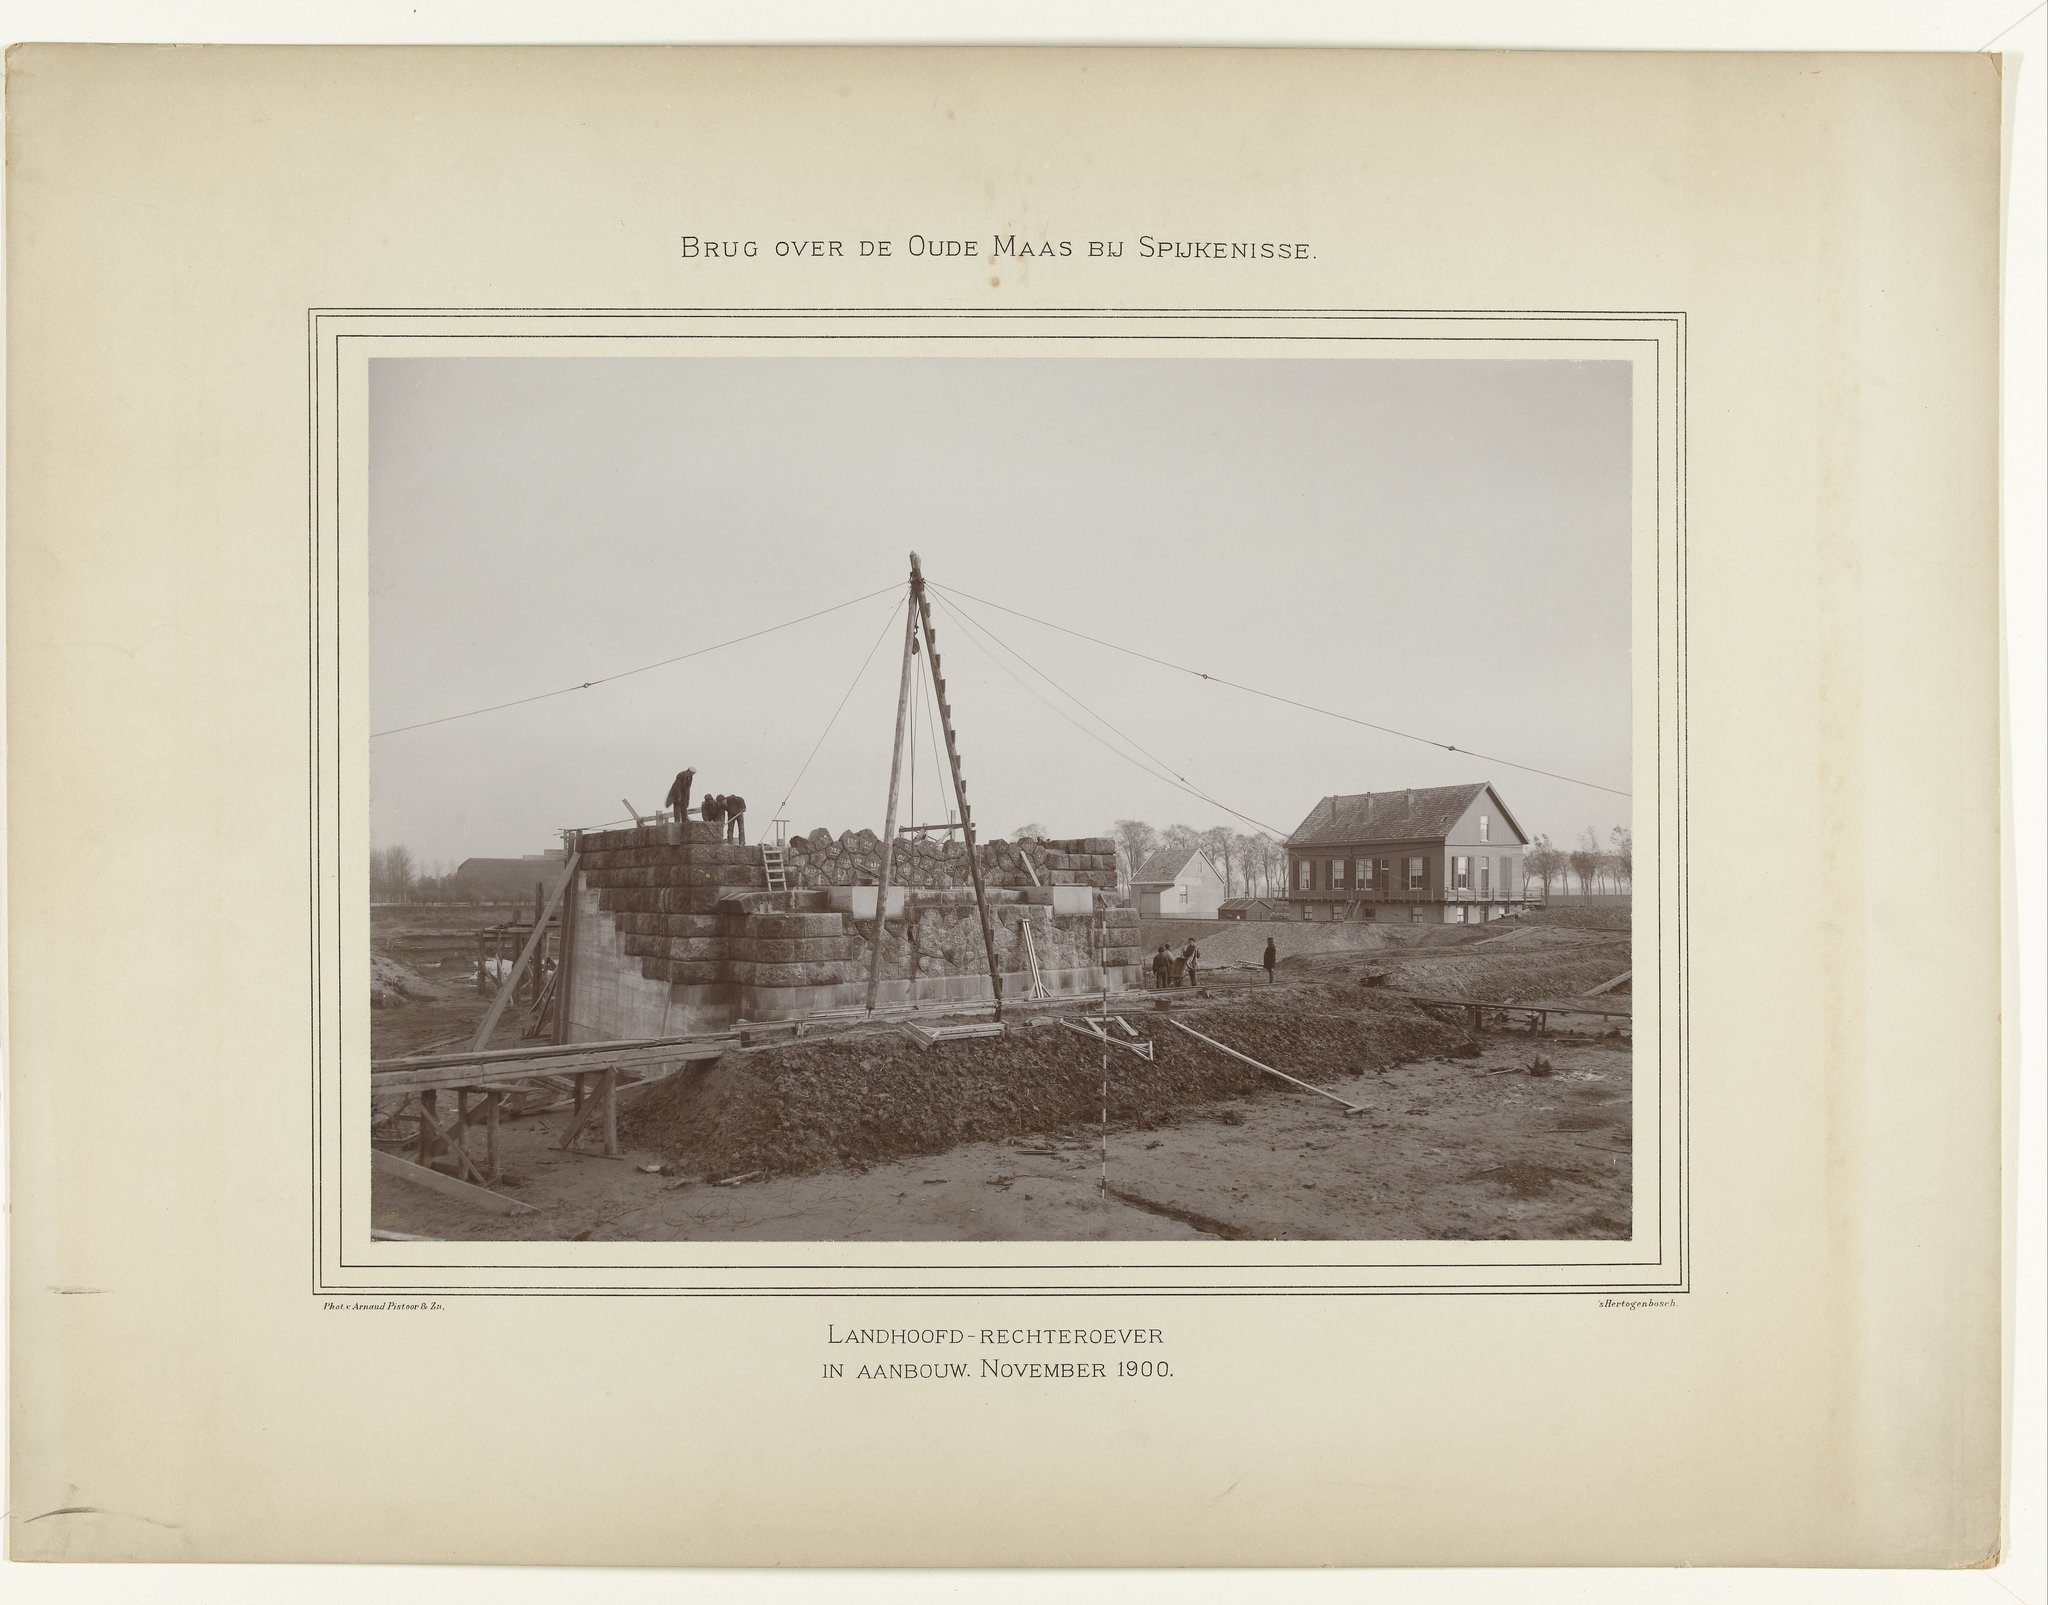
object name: photograph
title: Brug over de Oude Maas bij Spijkenisse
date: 1900-1911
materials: cardboard, photographic support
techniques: collodion silver print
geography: den bosch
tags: building-site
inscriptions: date